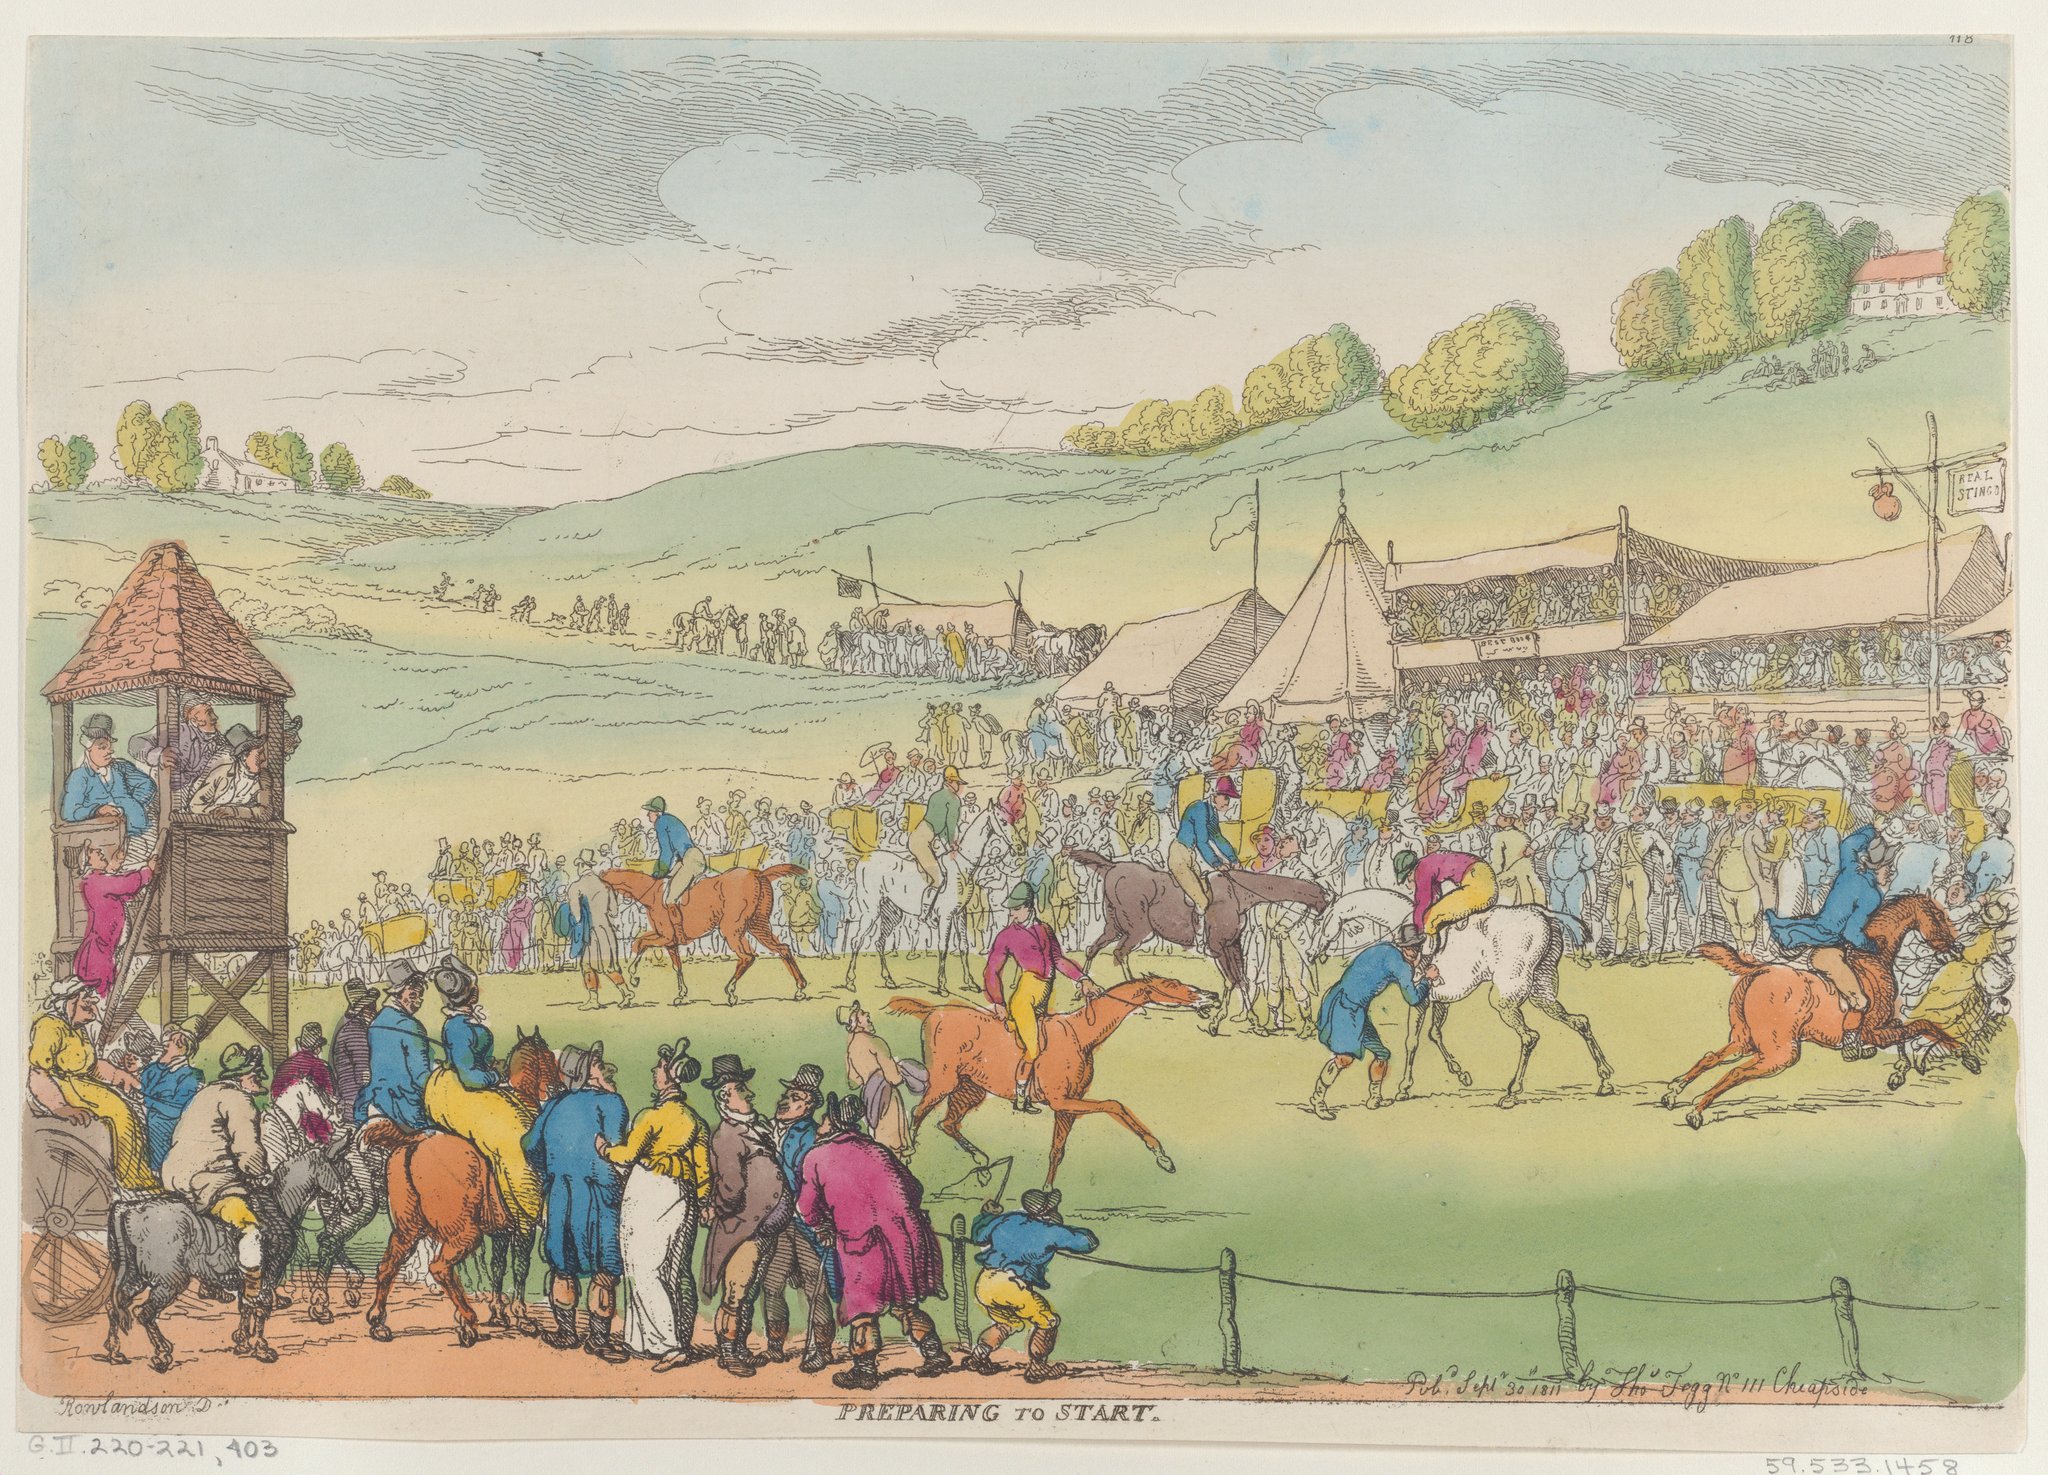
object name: print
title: Preparing to Start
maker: thomas rowlandson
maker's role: artist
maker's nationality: british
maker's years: 1757-1827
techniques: etching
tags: spectators,horses,jockeys